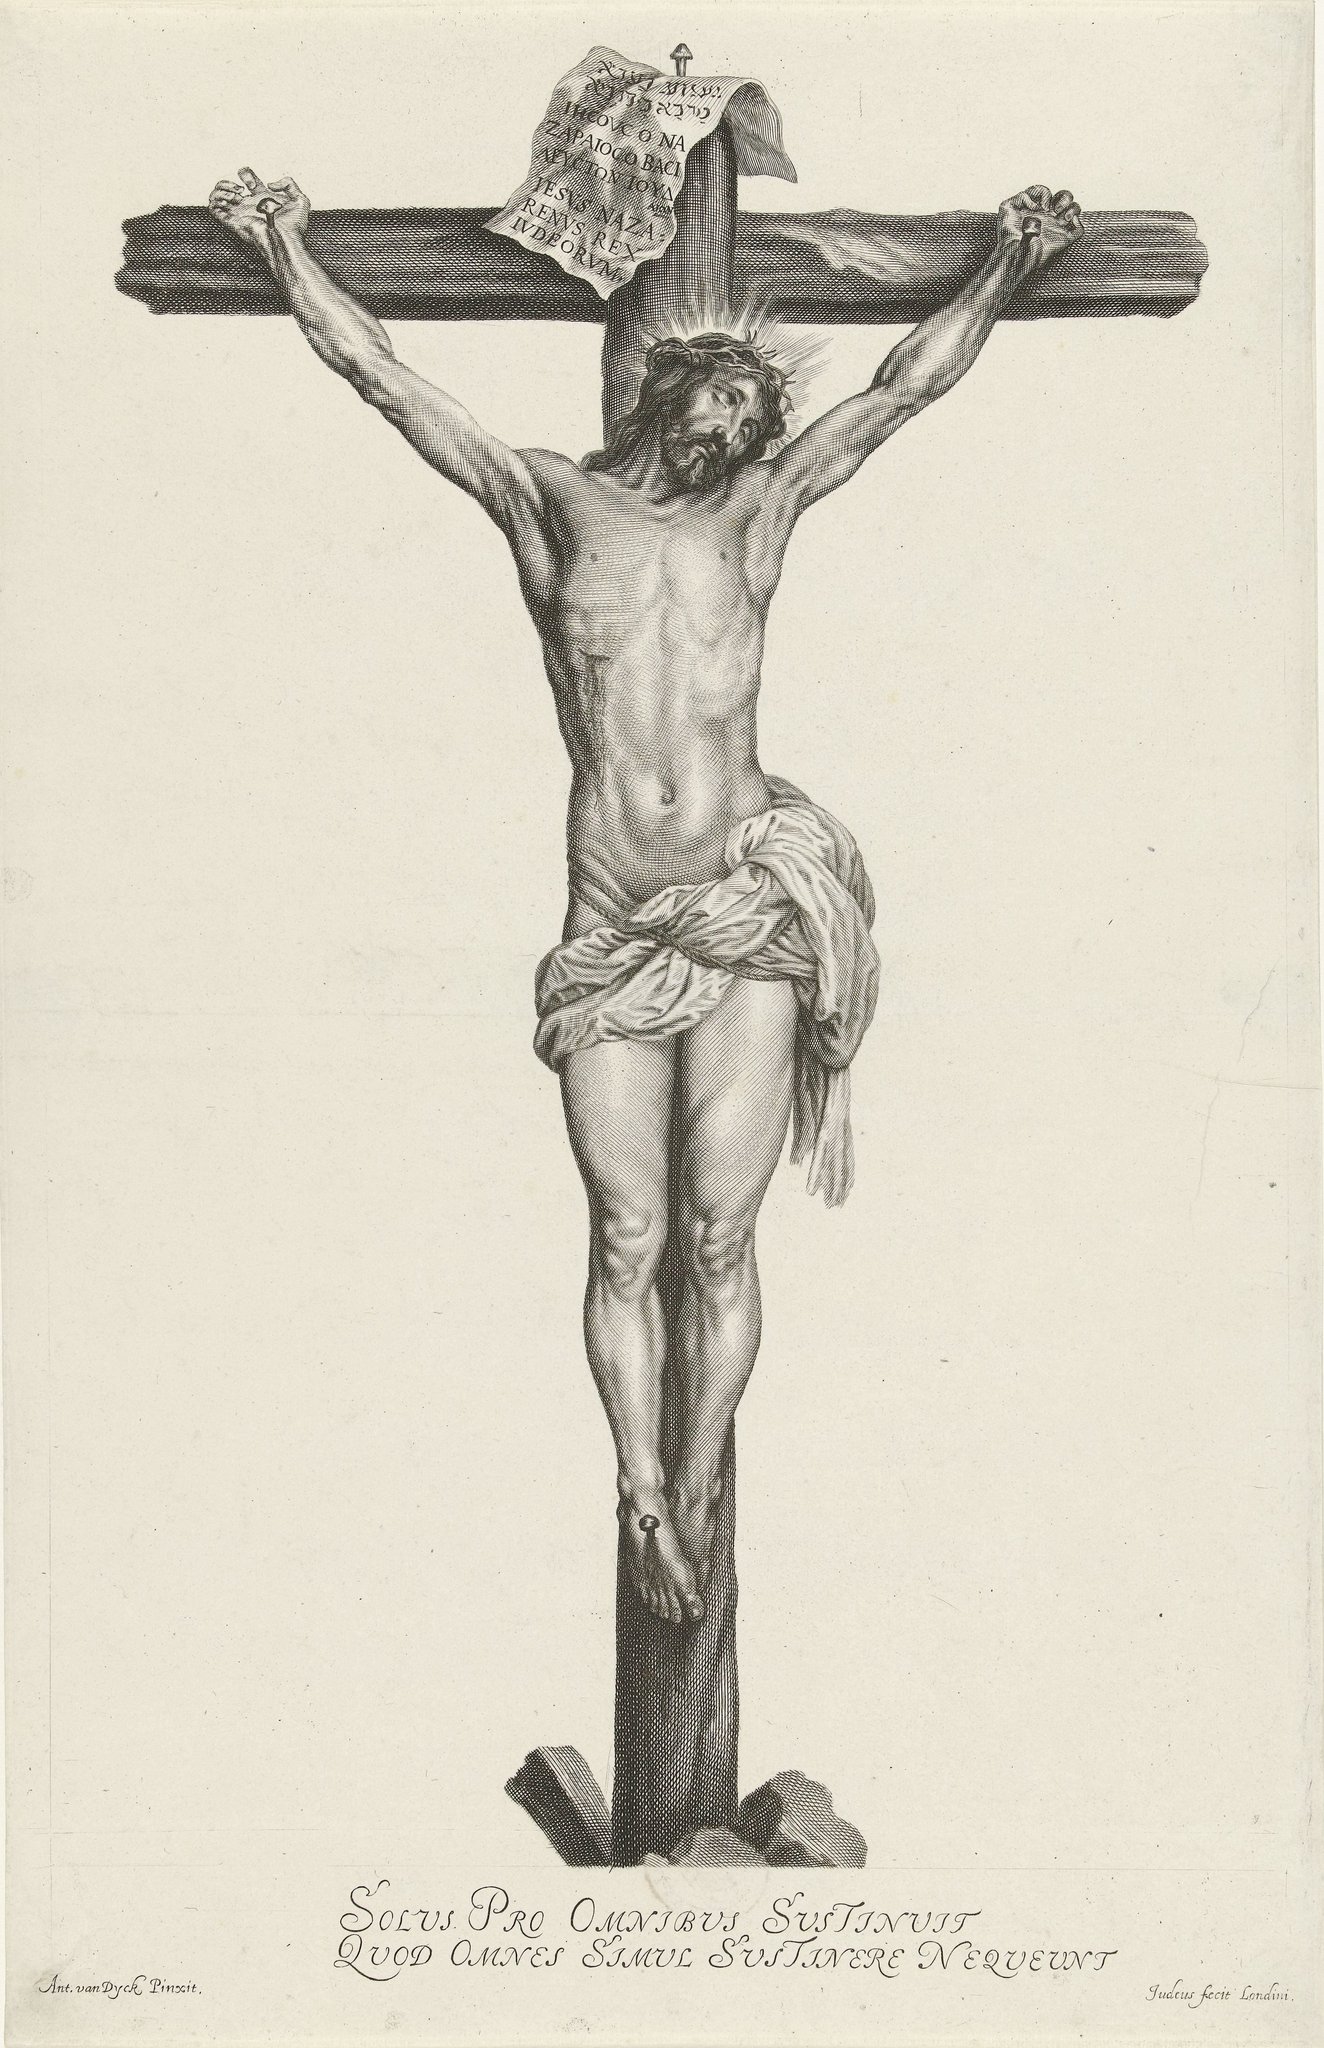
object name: print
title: Christus aan het kruis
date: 1666-1667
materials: paper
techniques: engraving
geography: london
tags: christ on the cross on golgotha (alone, without bystanders)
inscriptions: collector's mark: Lugt 240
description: Christus aan het kruis. Aan het kruis is een papier met een opschrift genageld: 'Jezus van Nazareth, koning van de Joden' in het Hebreeuws, het Grieks en het Latijn. Onder de voorstelling een tweeregelig onderschrift in het Latijn.